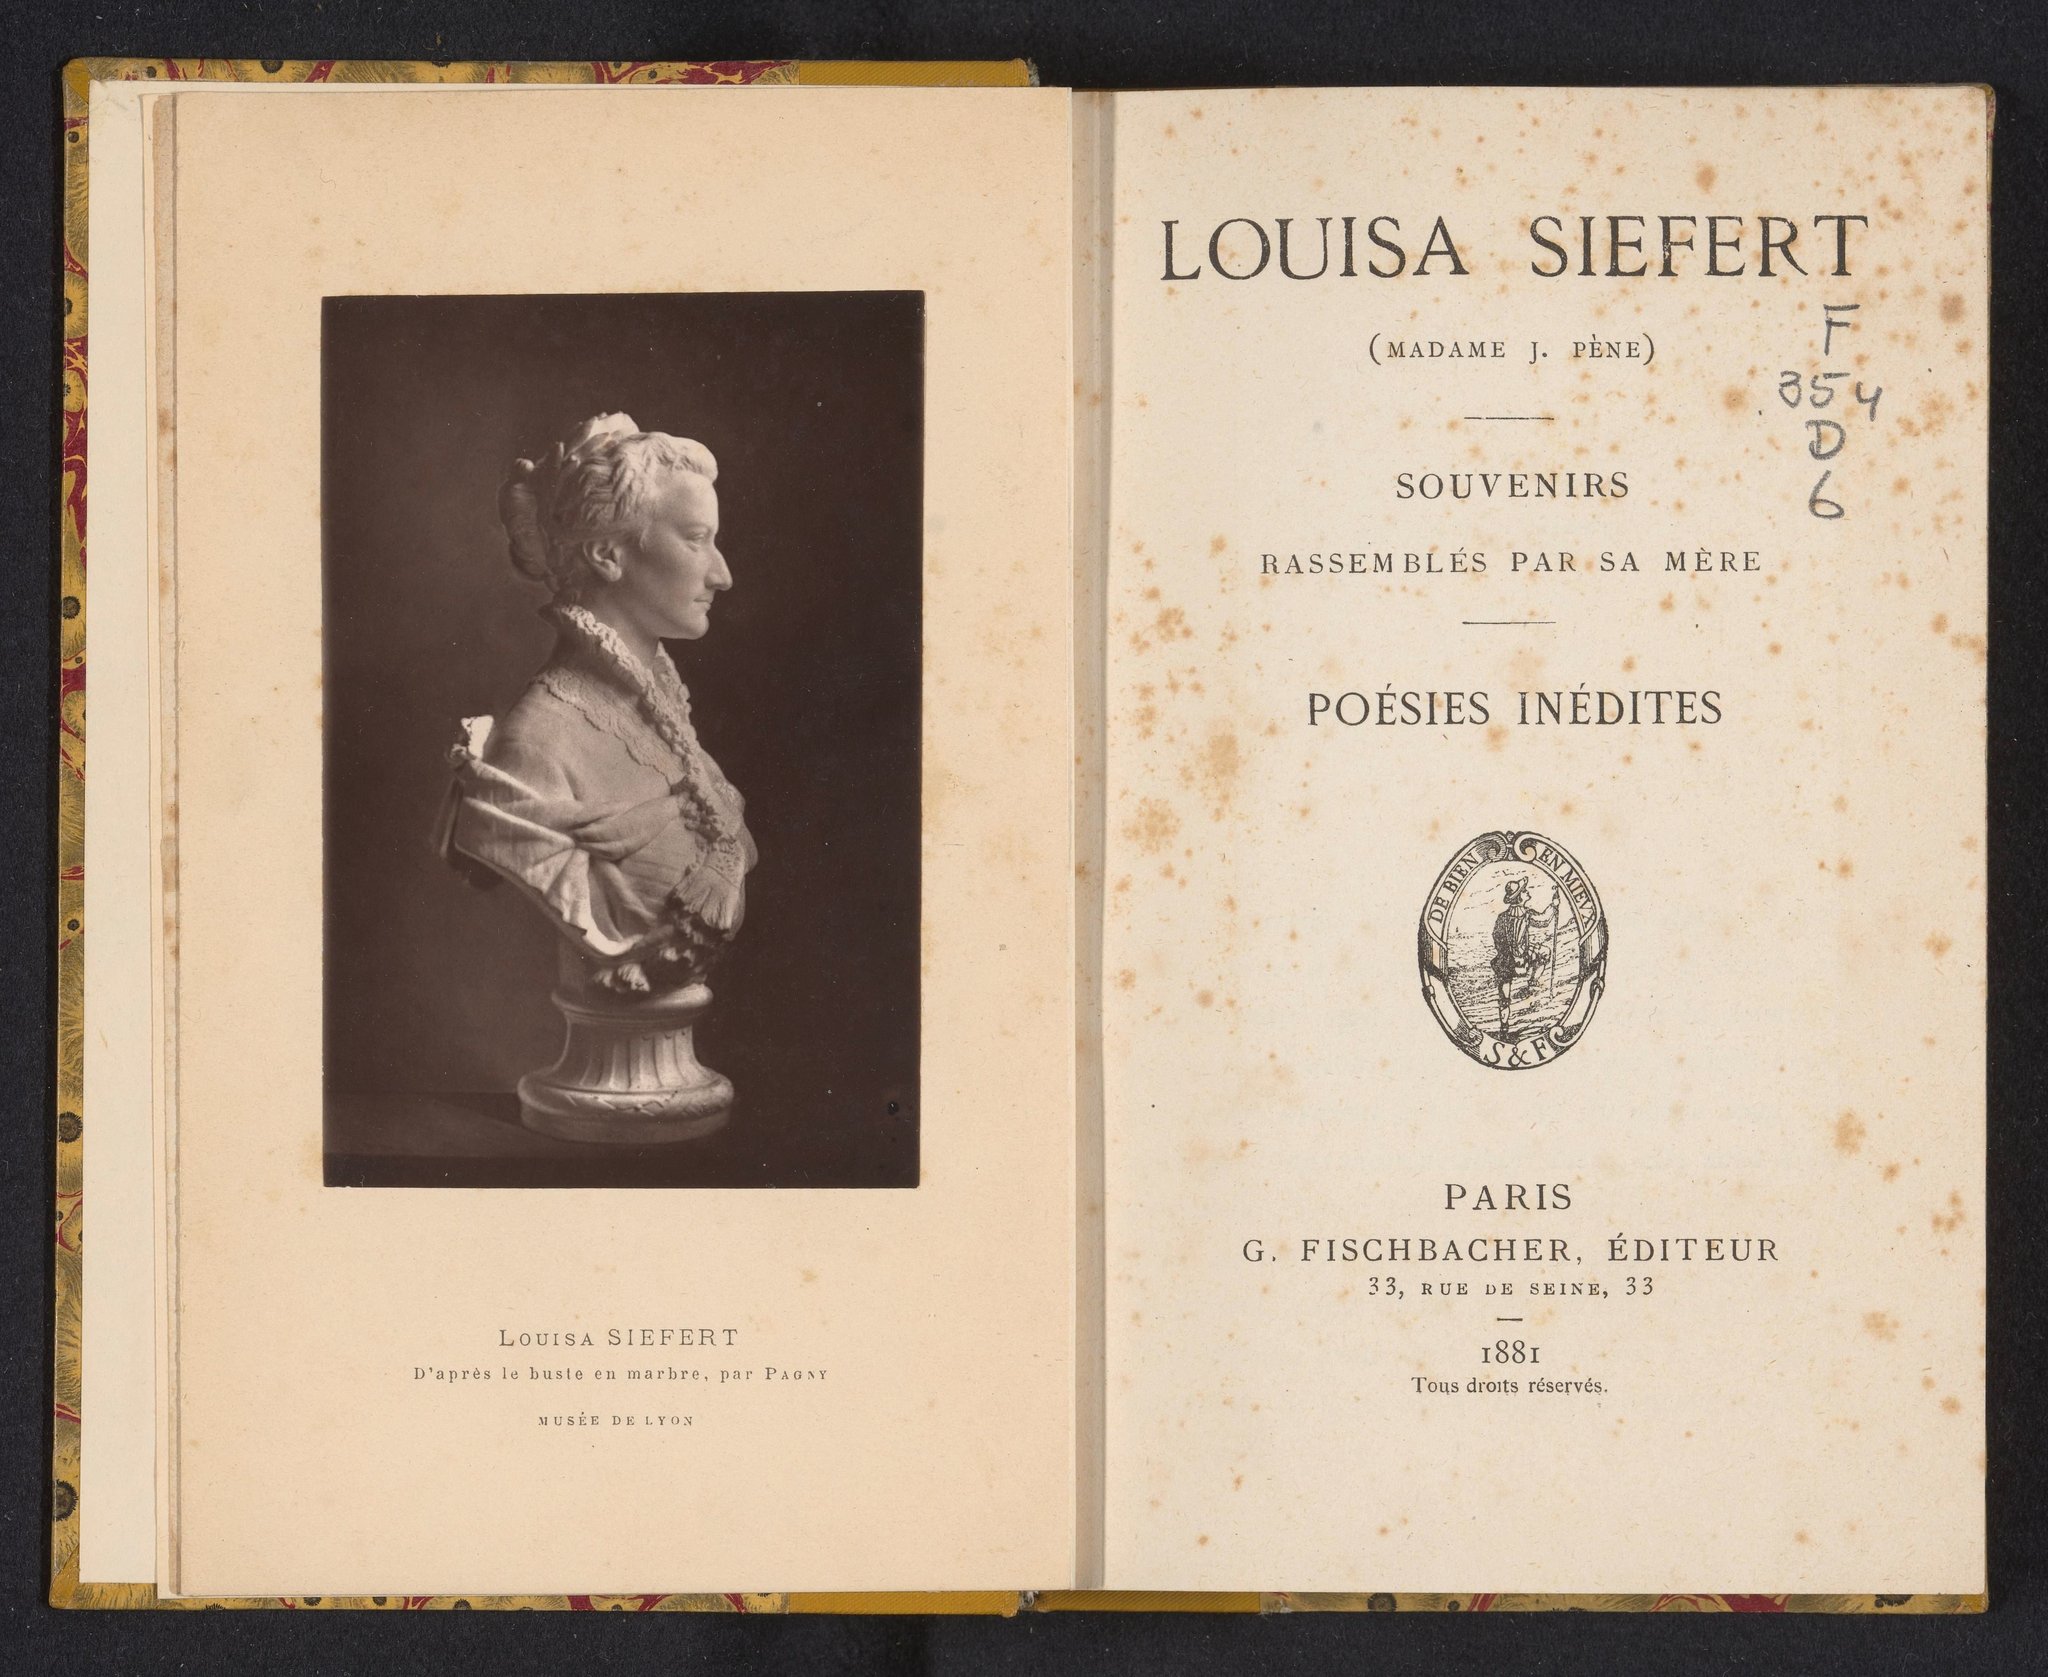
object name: book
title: Louisa Siefert (Madame J. Pène) : souvenirs rasemblés par sa mère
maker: louisa siefert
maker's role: dichter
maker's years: 1845-1877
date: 1881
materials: cardboard, linen, paper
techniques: printing, marbling, woodburytype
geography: paris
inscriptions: name: ‘Norette Geisendorf’